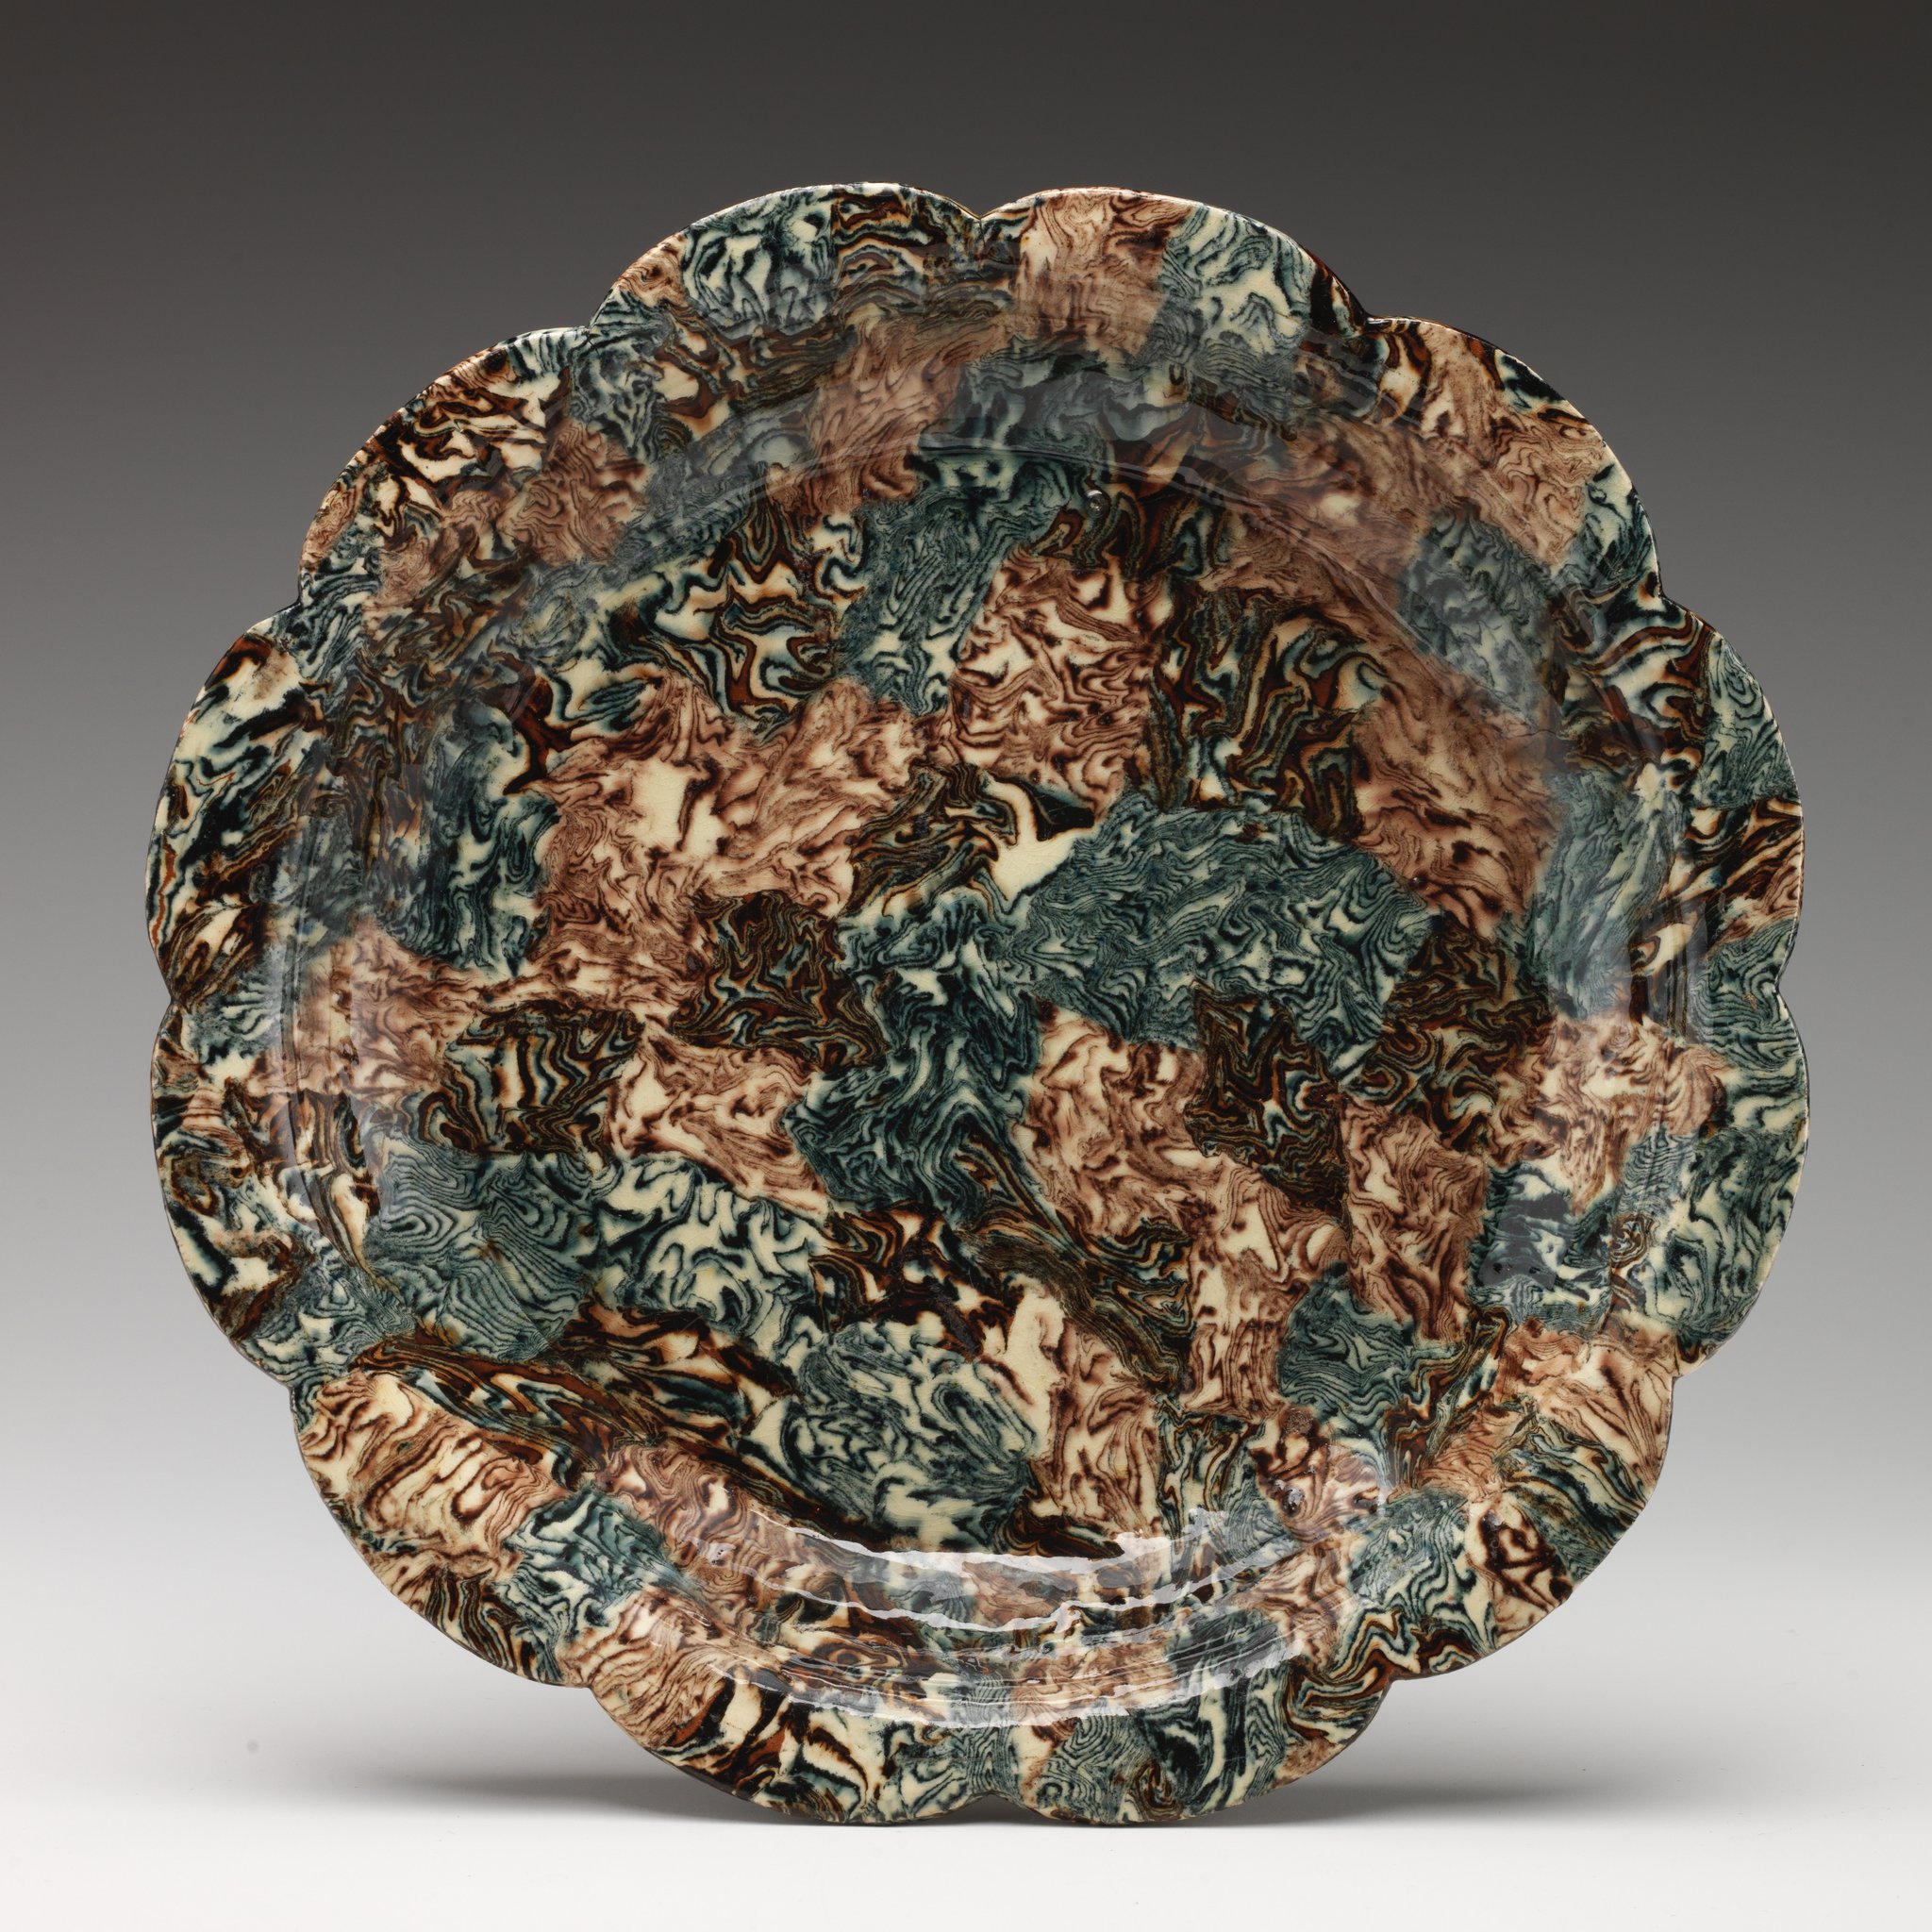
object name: plate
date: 1750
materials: earthenware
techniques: glazing